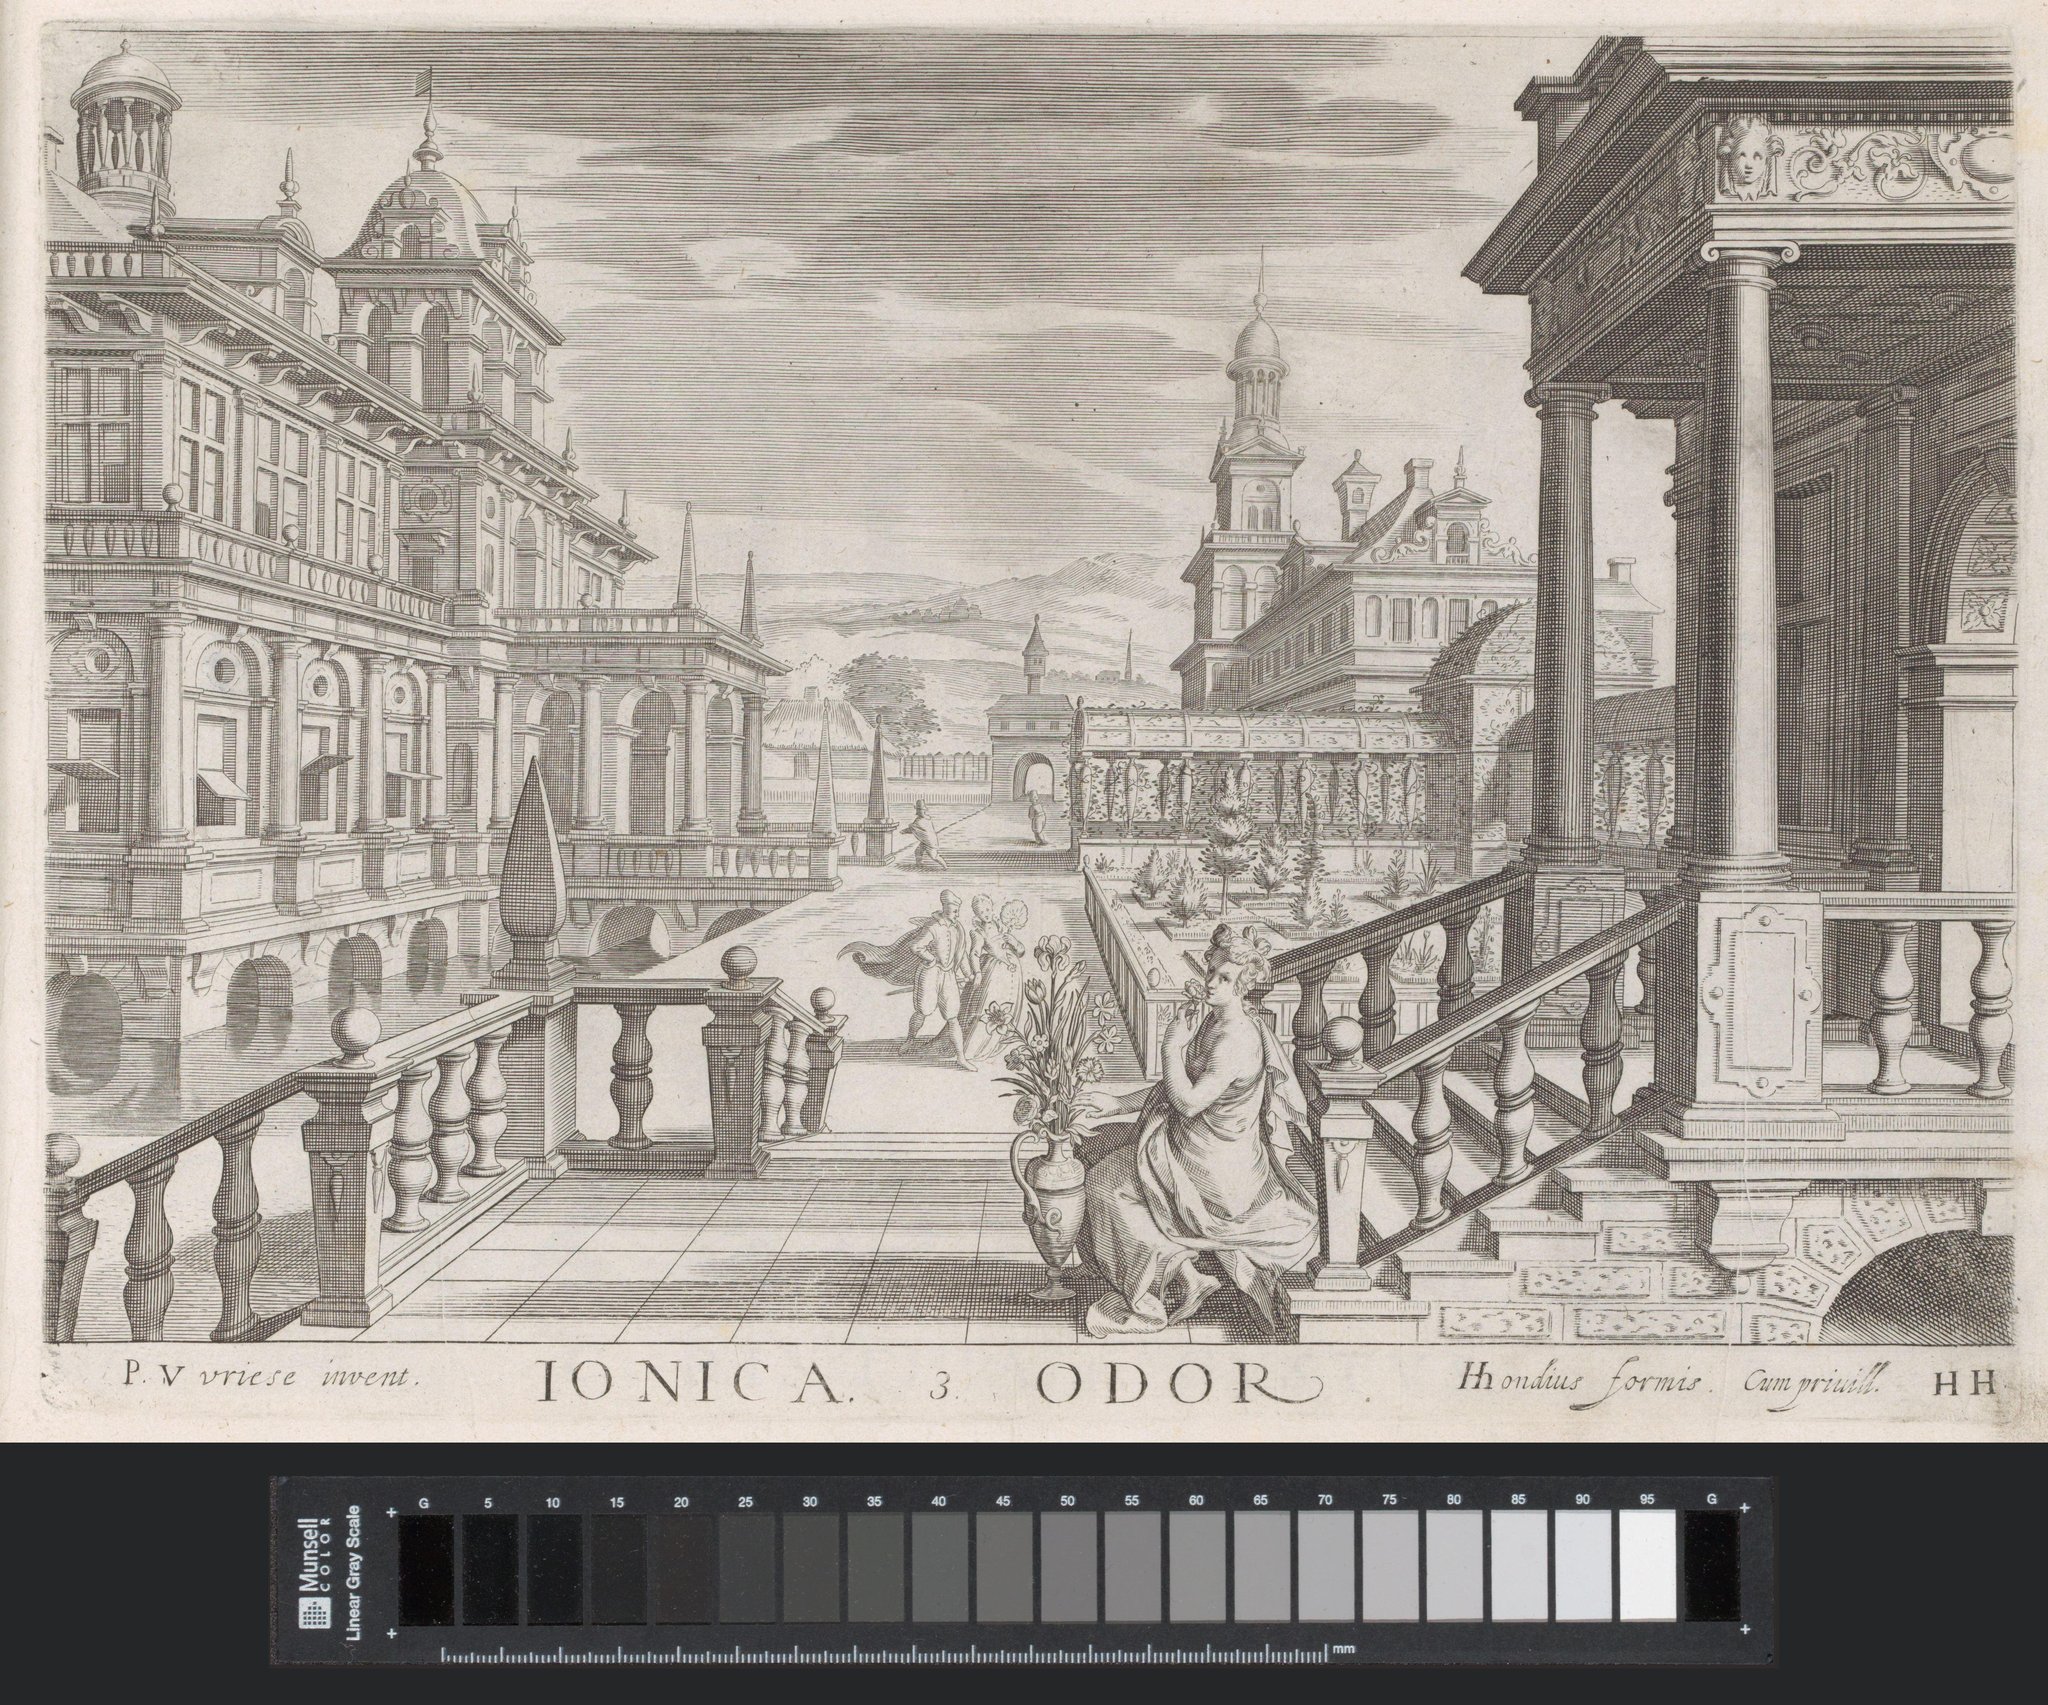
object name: print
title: Architectura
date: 1606-1607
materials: paper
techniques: engraving, etching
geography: amsterdam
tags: smell, smelling (one of the five senses), ionic order ~ architecture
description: Portaal van een gebouw met Ionische zuilen in een stadse omgeving. Op de voorgrond een vrouw die aan een bloem ruikt op de trap. Zij verbeeldt het zintuig reuk. Rechtsonder: HH. Prent maakt deel uit van een album.